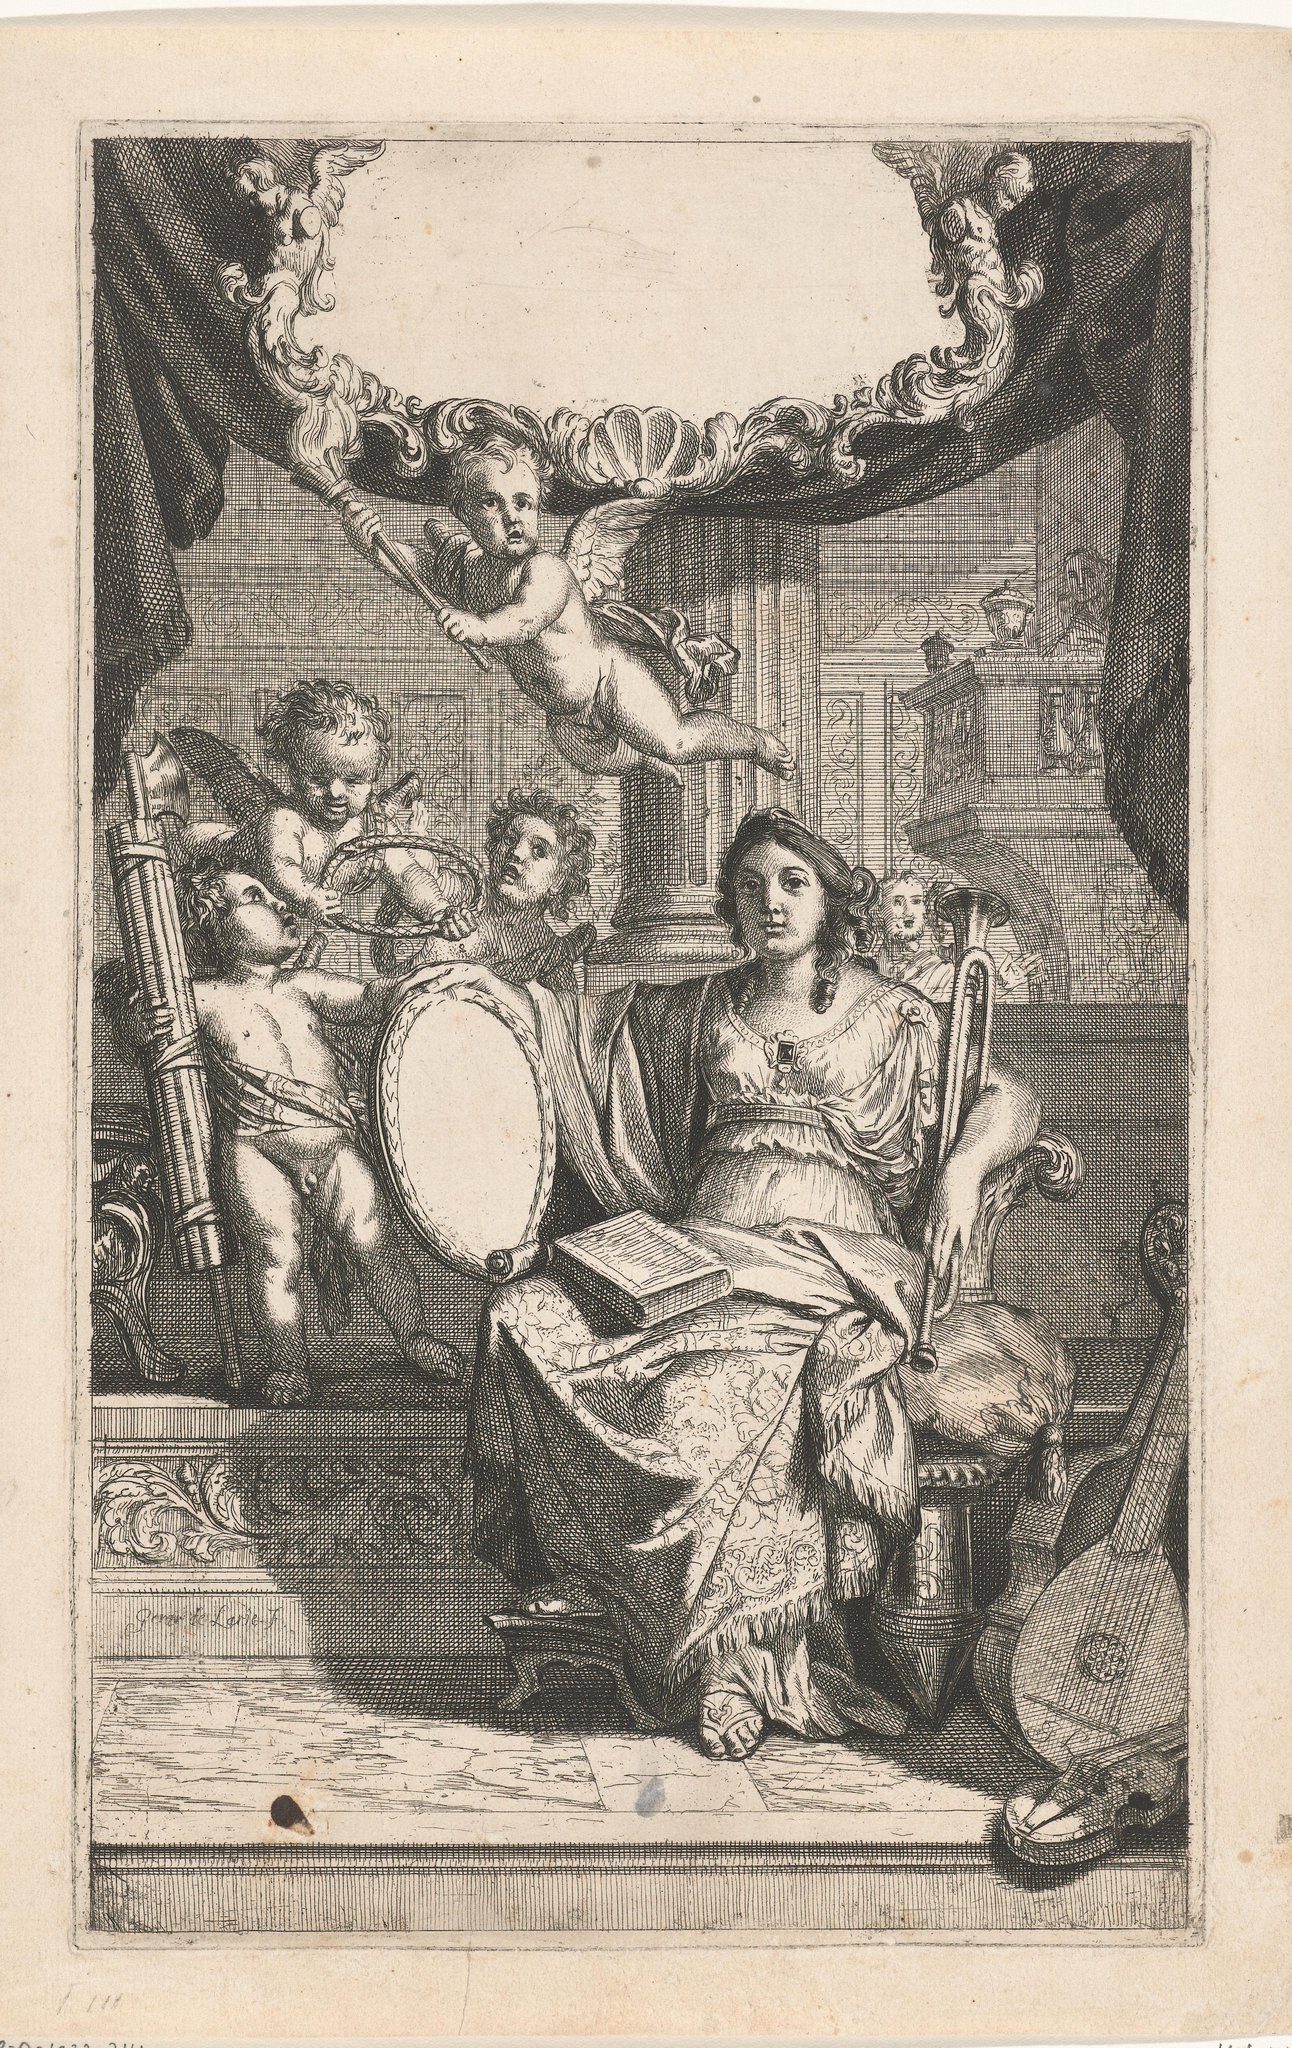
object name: print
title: Euterpe, muze van de muziek en lyriek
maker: gerard de lairesse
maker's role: draughtsman, painter, print maker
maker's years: 1641-1711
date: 1683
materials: paper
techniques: etching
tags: concord, 'concordia' ~ one of the seven gifts of the soul, violin, fiddle, serpent ouroboros, lute, and special forms of lute, e.g.: theorbo, other string instruments (plucked), euterpe (one of the muses); 'euterpe' (ripa), cupids: 'amores', 'amoretti', 'putti'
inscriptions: collector's mark: Lugt 2228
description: Euterpe, muze van de muziek en lyriek, zit met een trompet en een cartouche in haar handen op een stoel. Op haar schoot ligt een dichtgeslagen boek, naast haar liggen een viool, theorbe en een viola da gamba. Achter Euterpe vliegt een putto met een brandende toorts, links houden putti een fasces (symbool van eendracht) en een slang die zich in eigen staart bijt vast (symbool van eeuwigheid) vast.